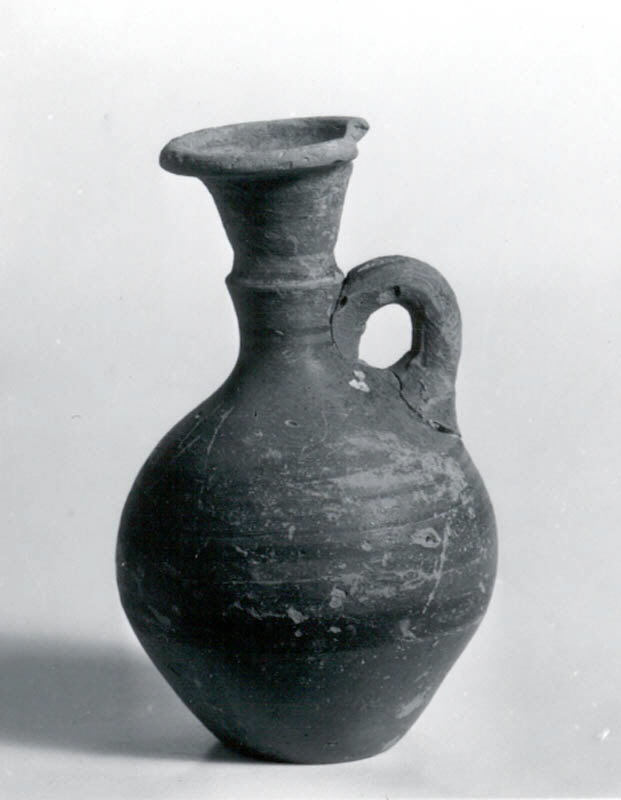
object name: jug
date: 734-601 BCE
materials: ceramic, paint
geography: levant